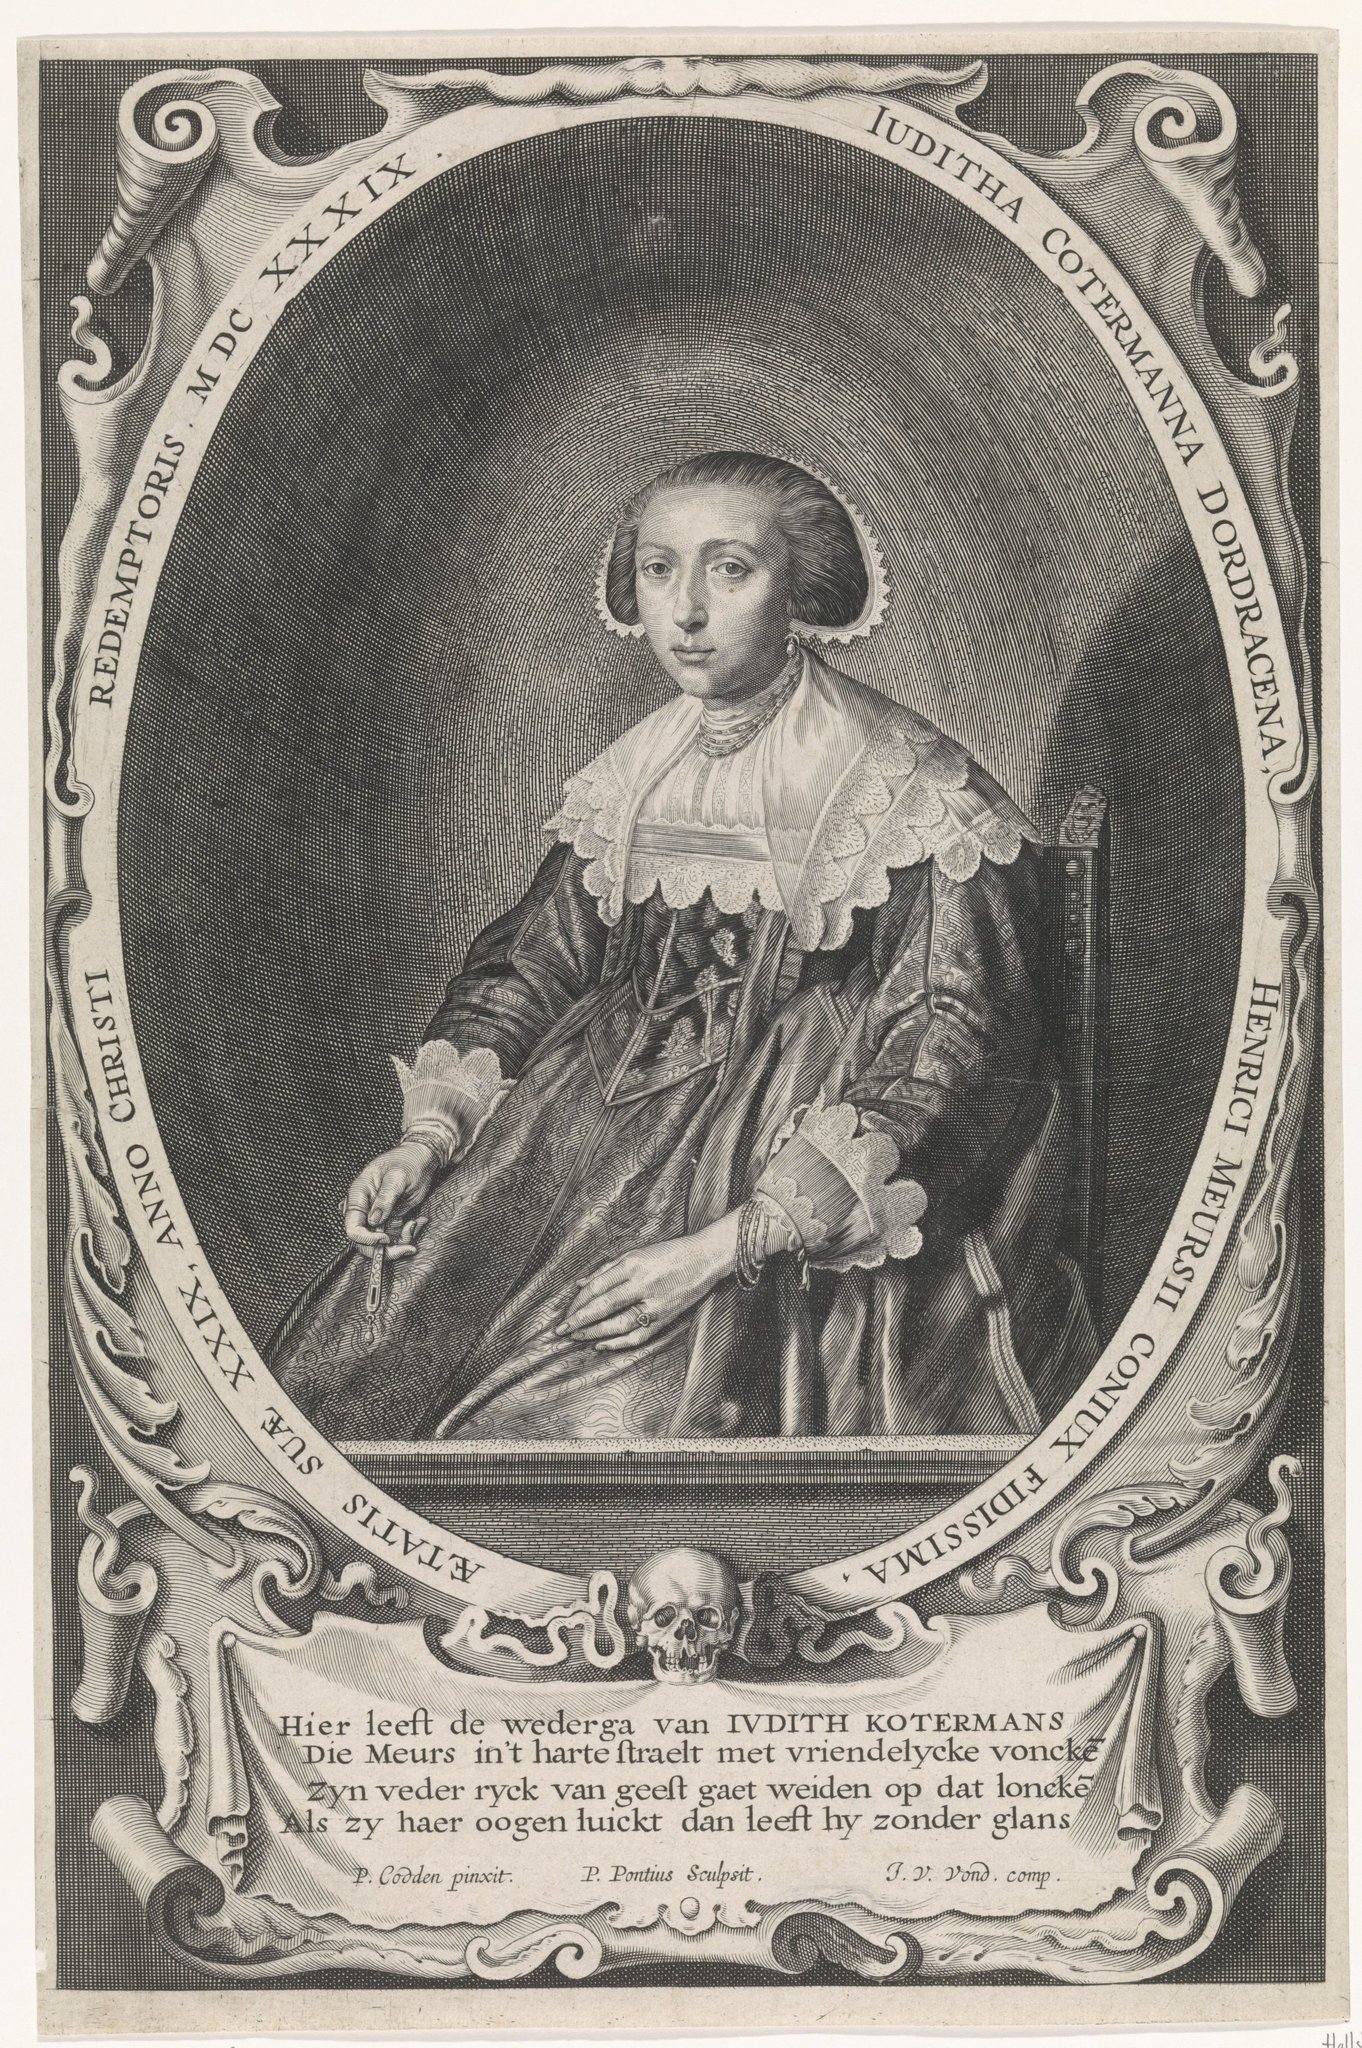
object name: print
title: Portret van Judith Cotermans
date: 1639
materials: paper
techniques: engraving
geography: antwerp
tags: judith cotermans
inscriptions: collector's mark: Lugt 2228, collector's mark: Lugt 963